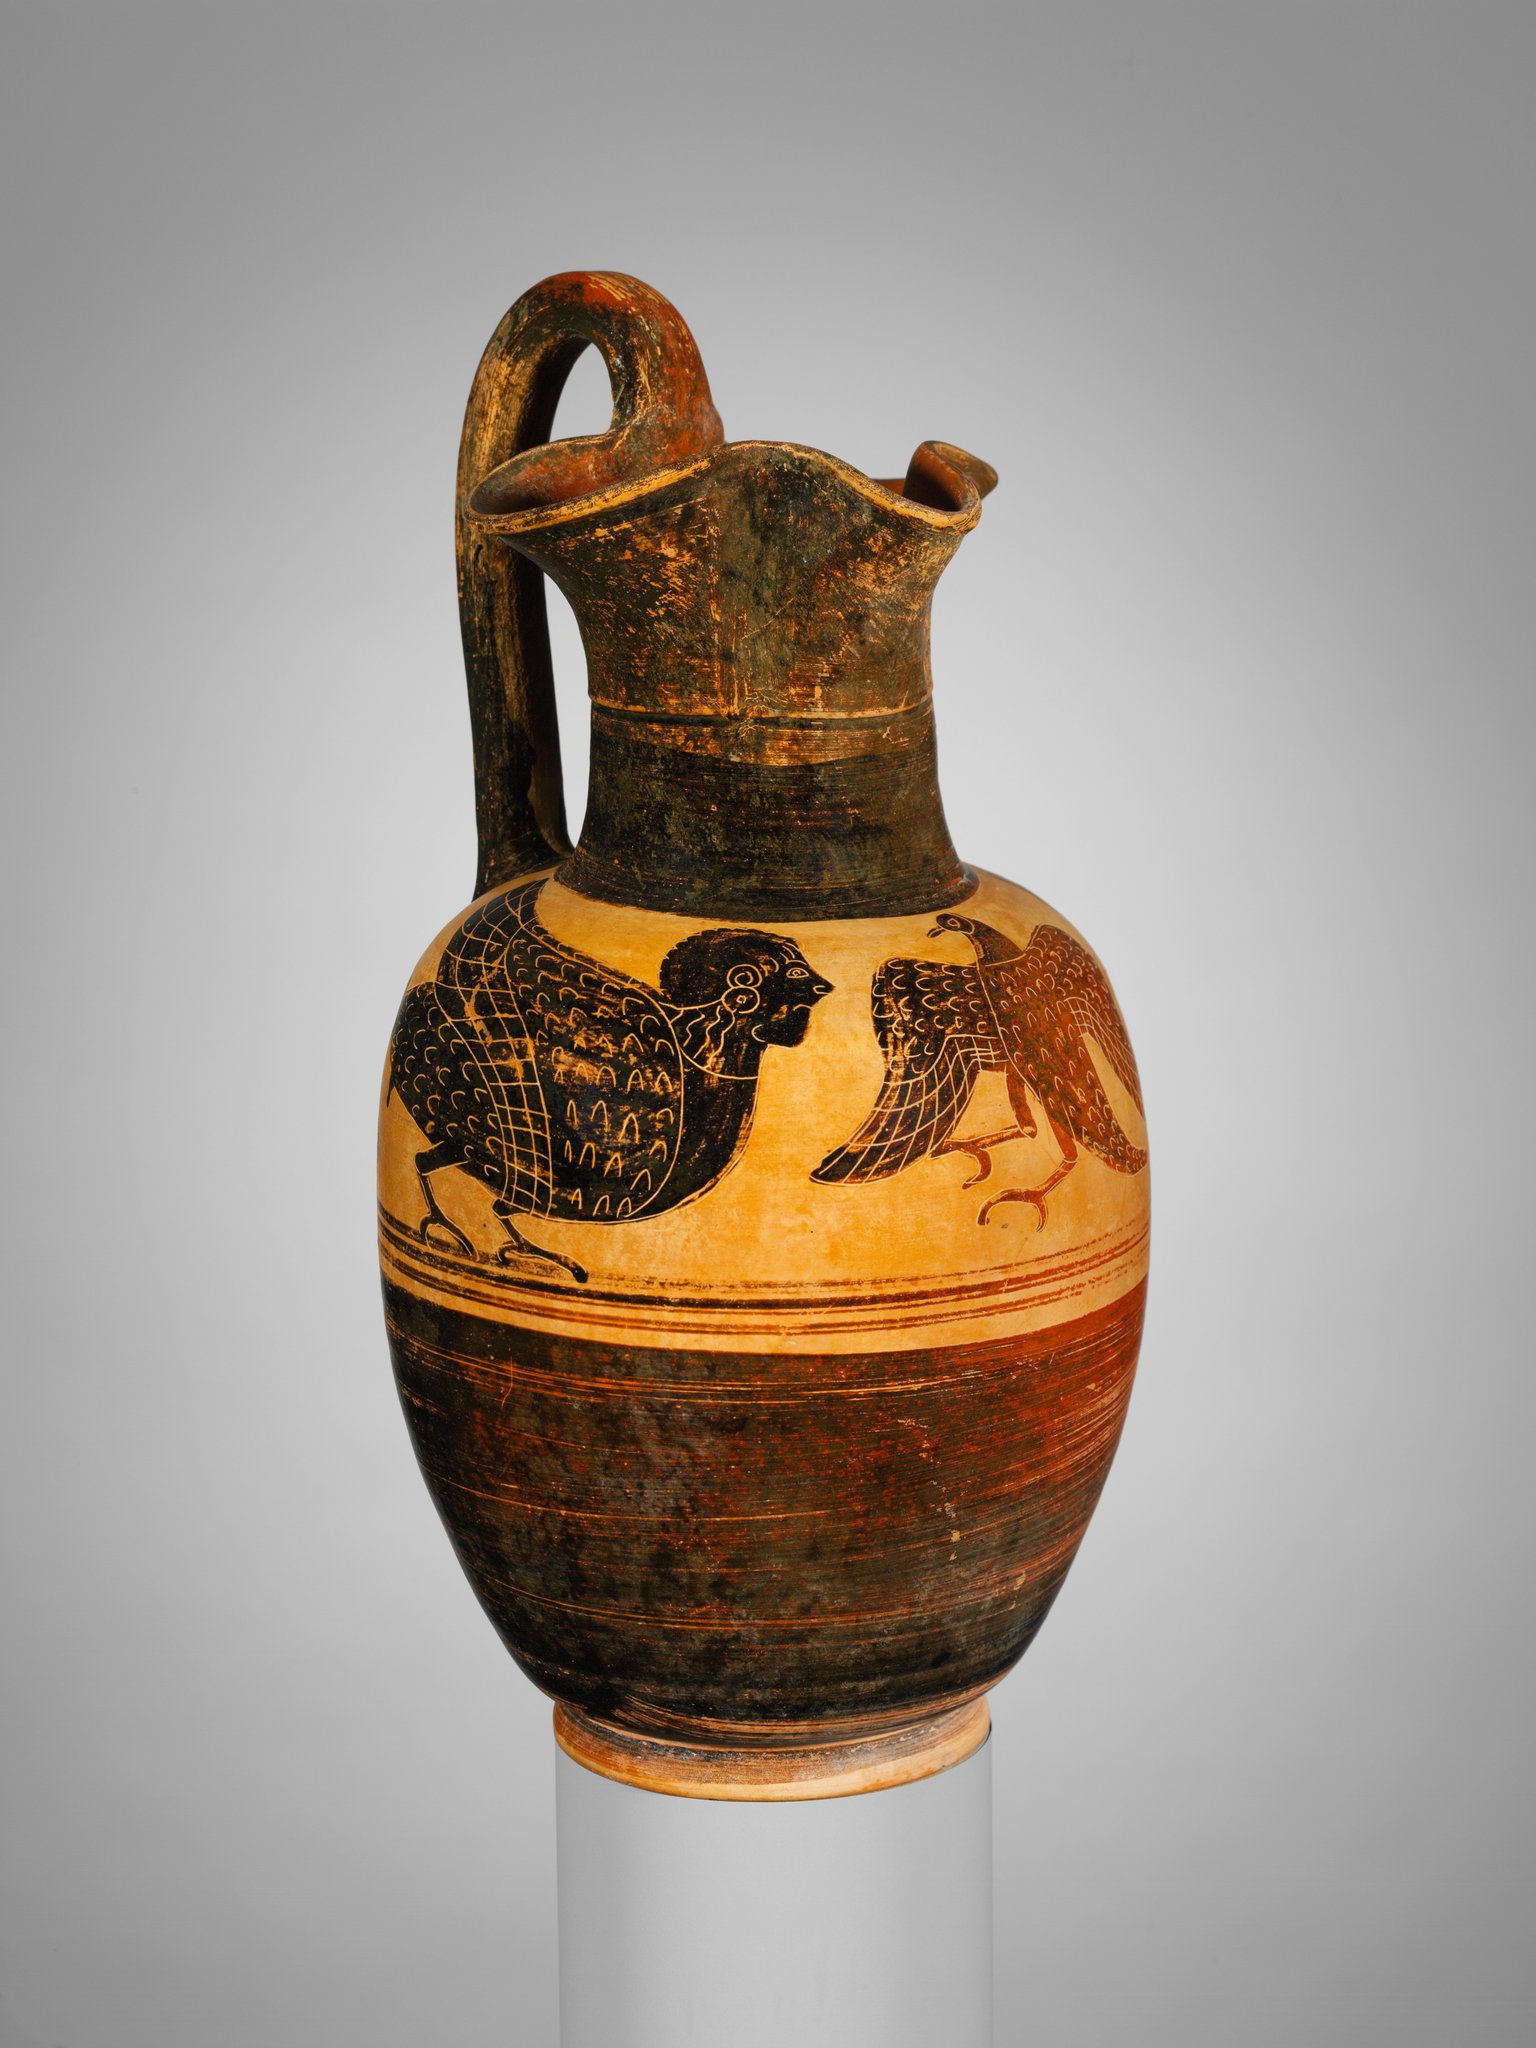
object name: oinochoe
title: Terracotta oinochoe (jug)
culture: etruscan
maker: micali painter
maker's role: artist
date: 525-500 BCE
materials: terracotta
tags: eagles,sirens